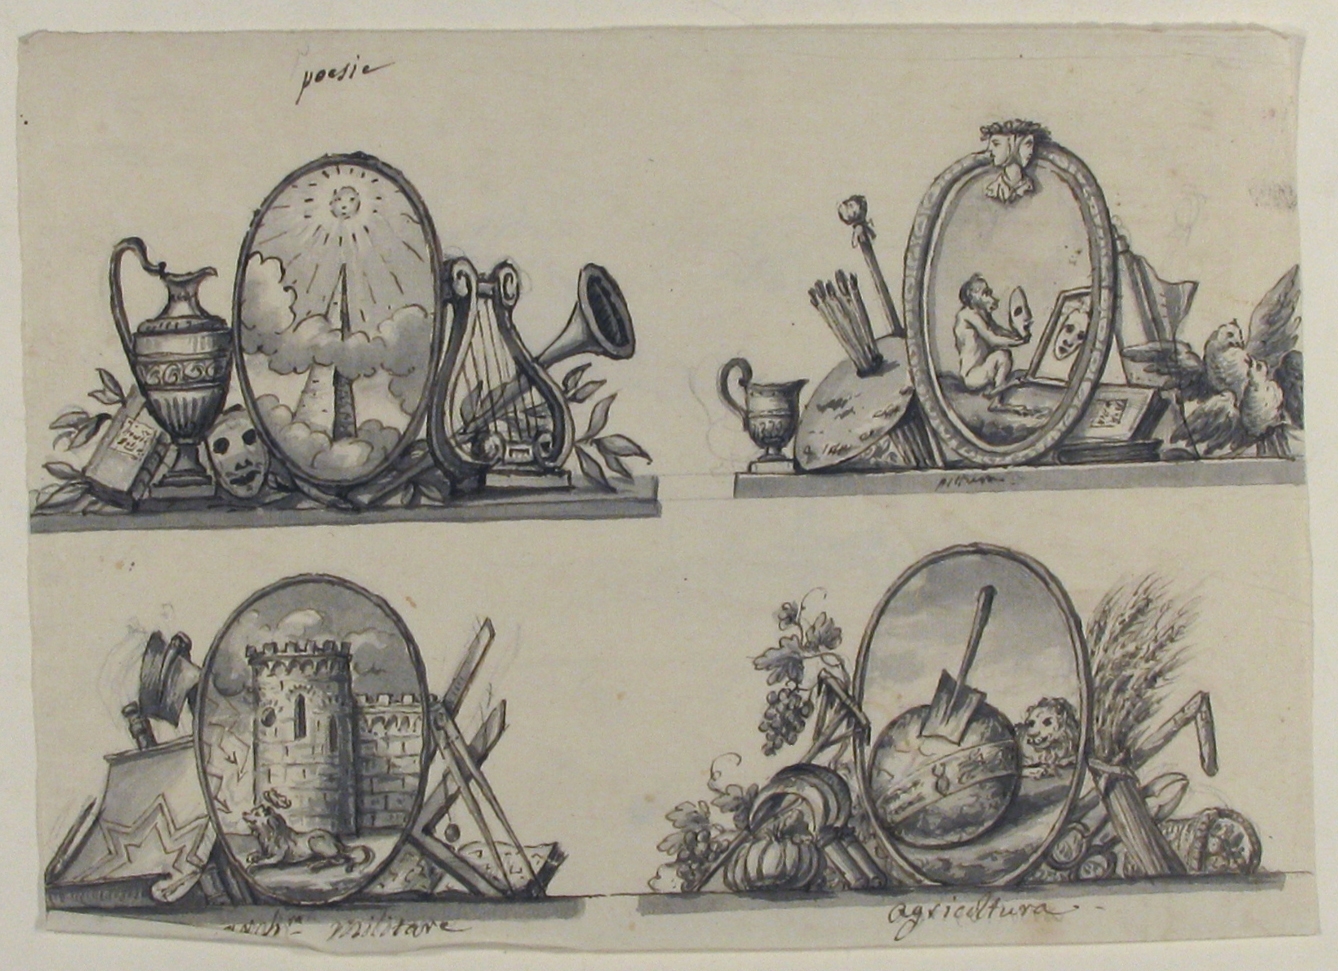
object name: drawing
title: Four Designs for Emblems (recto); Sketch of Three Putti (verso)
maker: anonymous, french, 18th century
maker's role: artist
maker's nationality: french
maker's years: 1700-1800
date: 1701-1800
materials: ink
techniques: brush, pen, wash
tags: musical instruments,birds,castles,lions